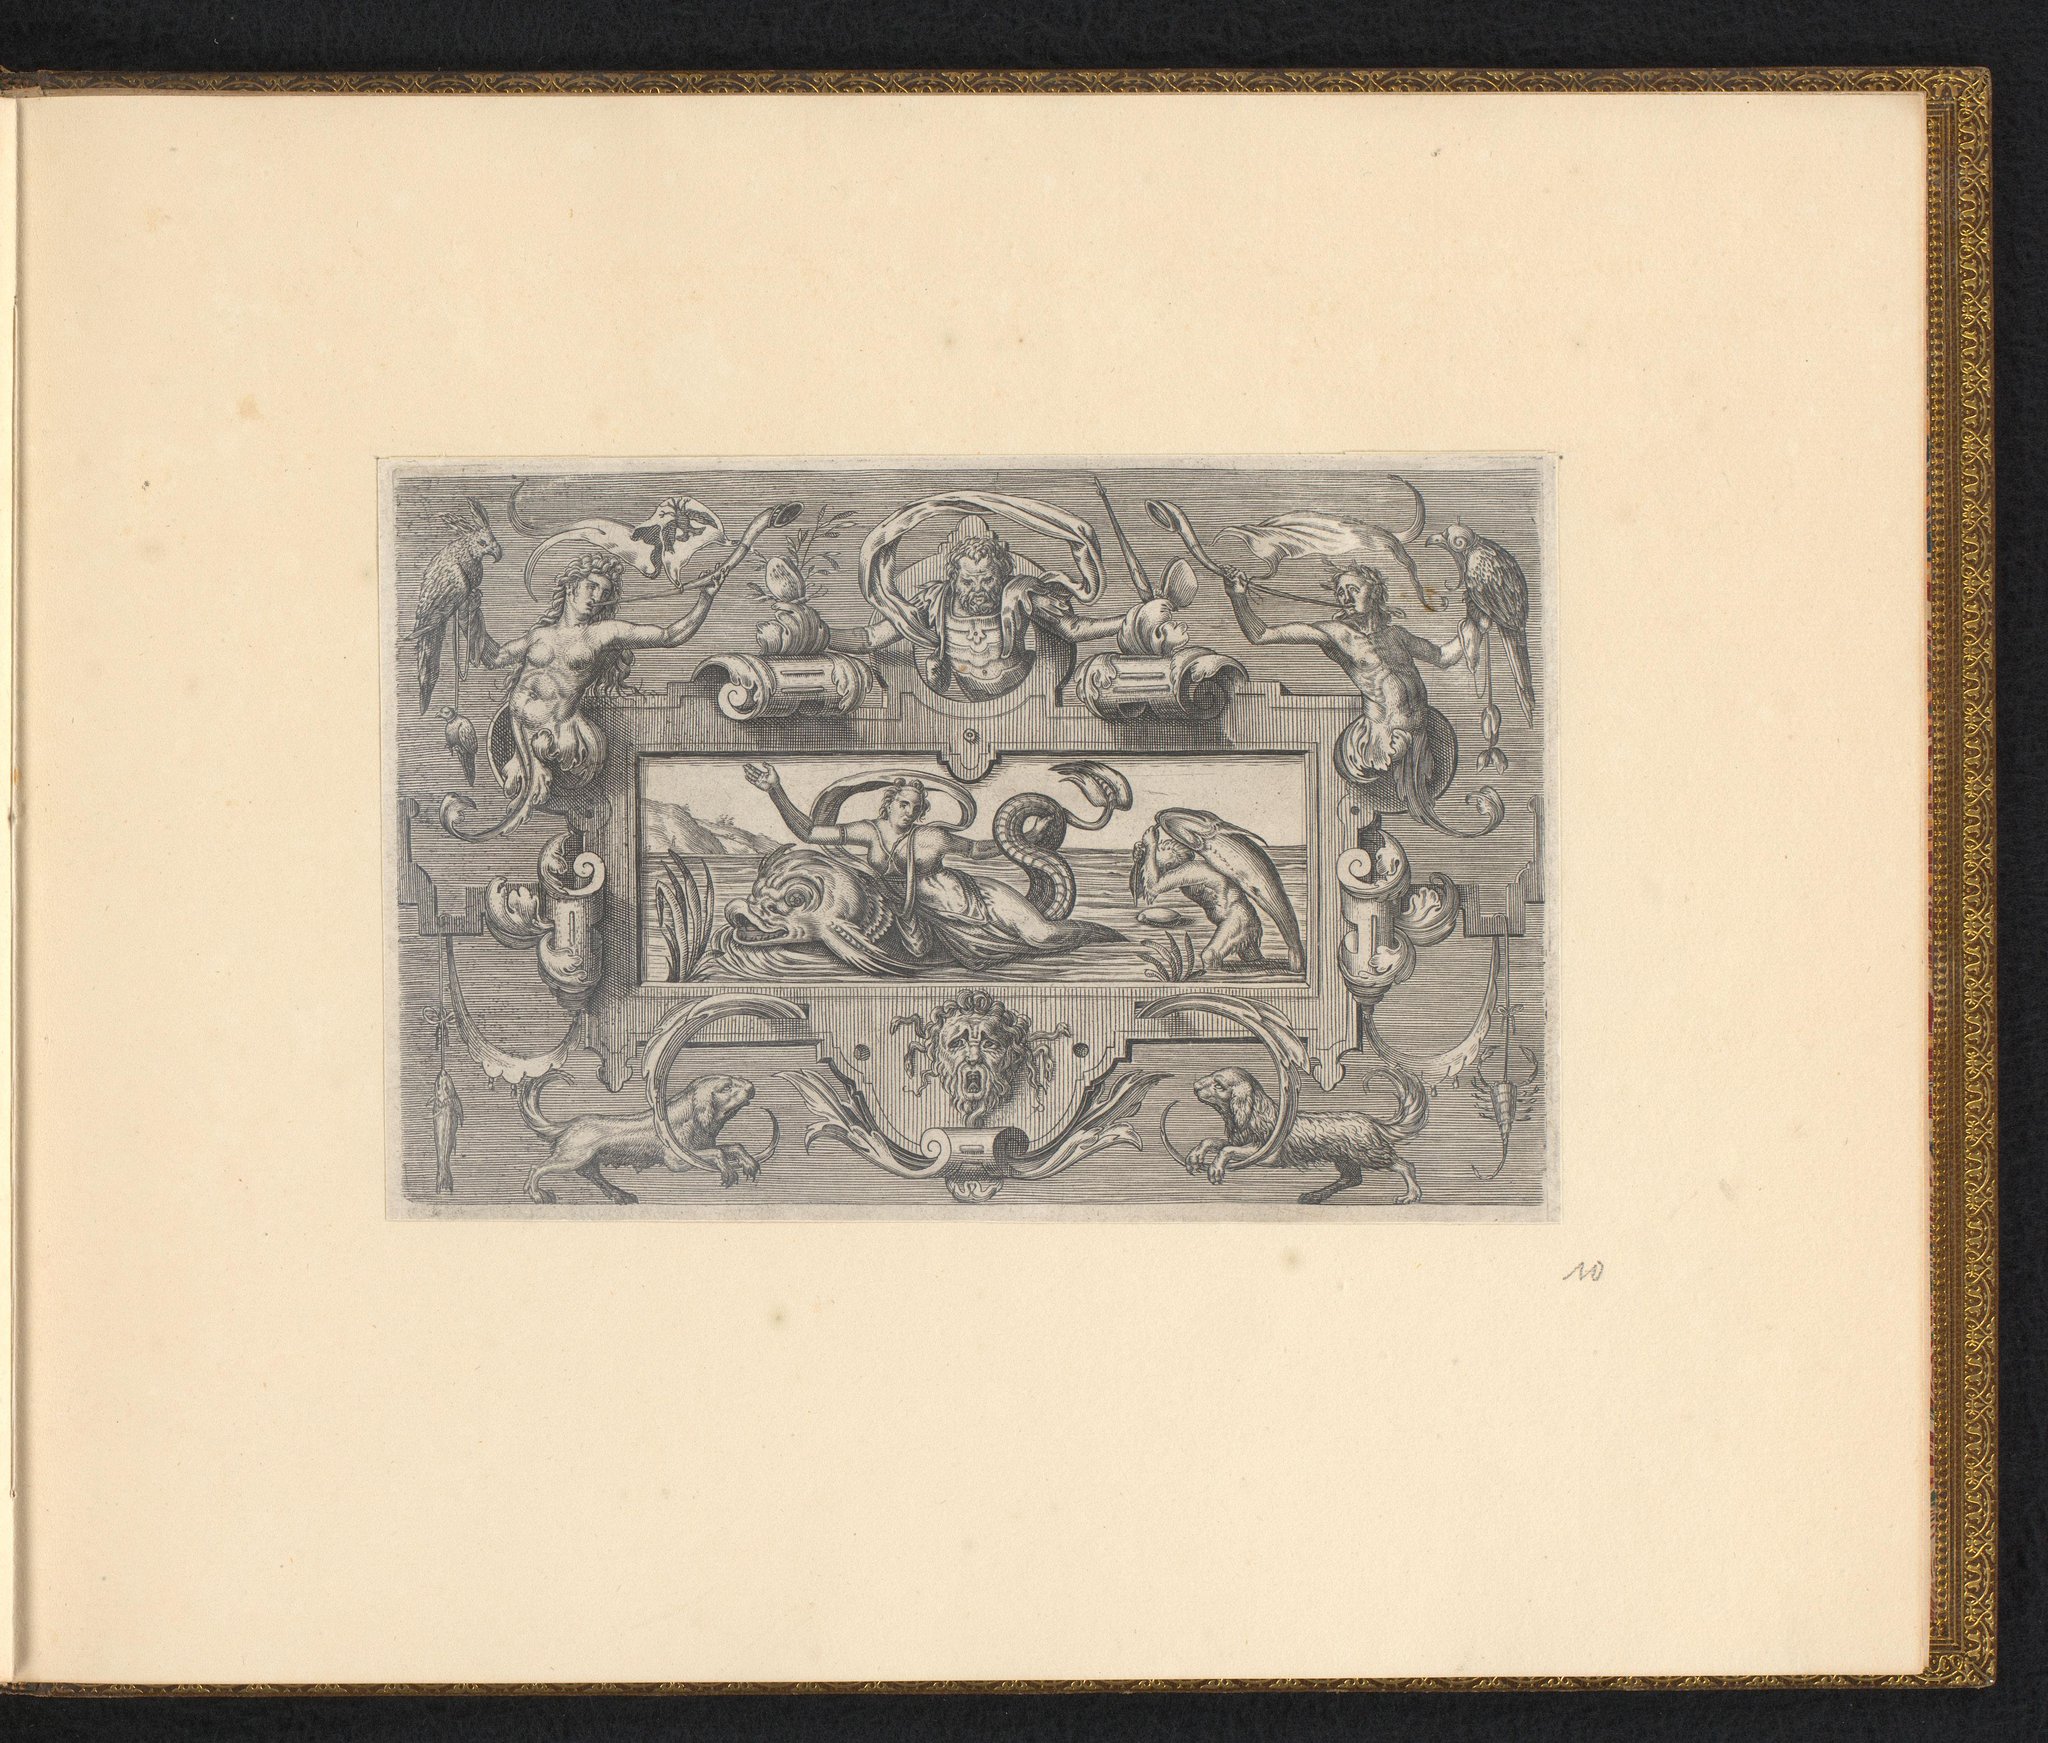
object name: ornament print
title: Cartouche met een vrouw op een zeemonster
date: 1564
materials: paper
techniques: engraving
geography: amsterdam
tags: fabulous animals (sometimes wrongly called 'grotesques'); 'mostri' (ripa), scrollwork, strapwork ~ ornament, ornament ~ cartouche, dog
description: Cartouche met een vrouw op een zeemonster en een man die een vis op zijn rug draagt. Midden bovenaan steekt een geharnaste man zijn bovenlijf door het rolwerk. Links en rechts daarvan blazen twee figuren op een hoorn. Onderaan een mascaron geflankeerd door honden. De prent maakt deel uit van een album.